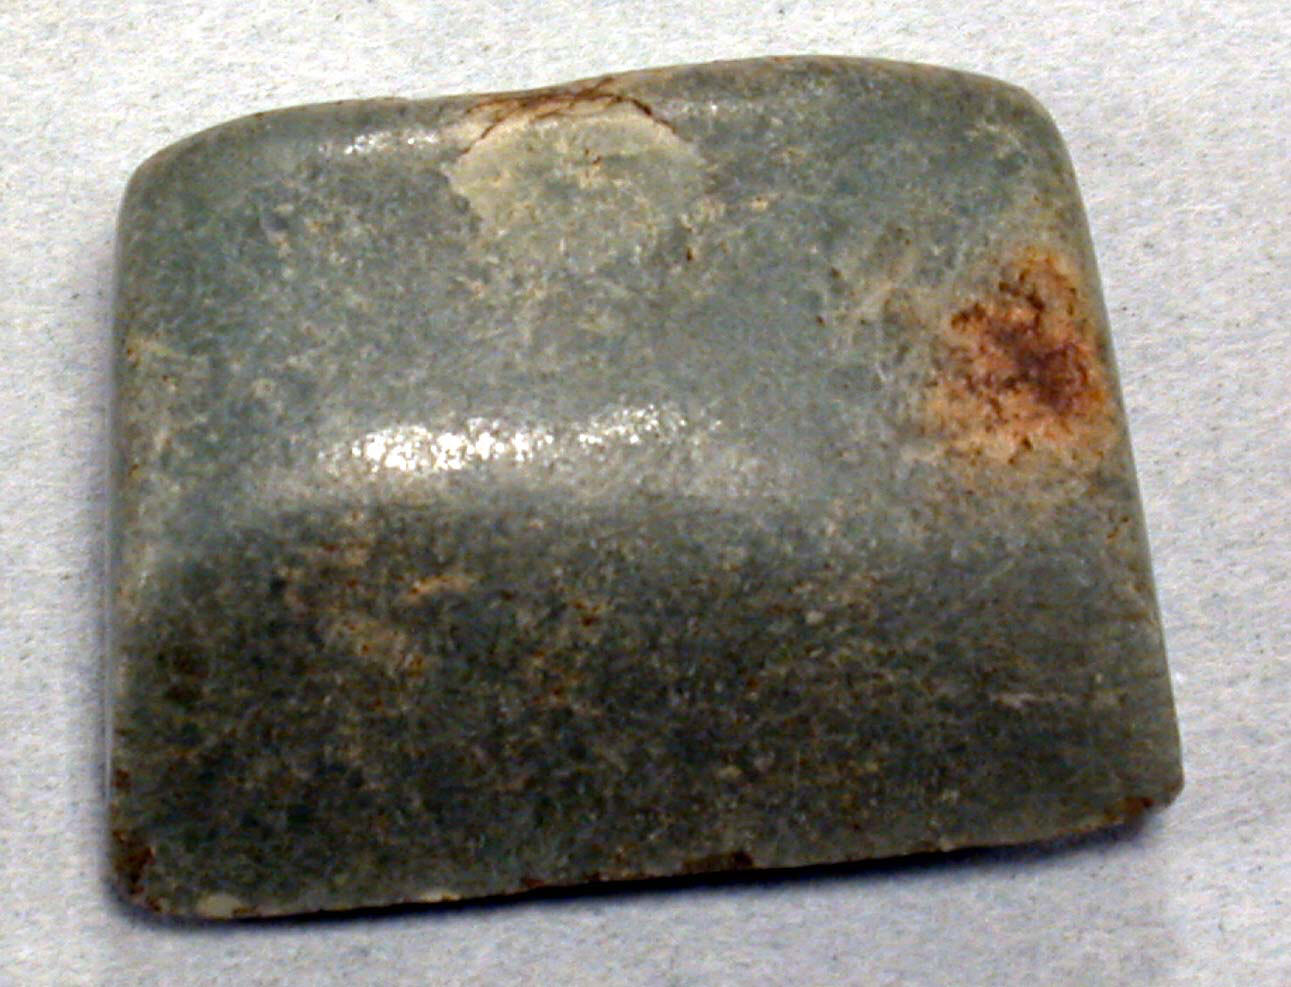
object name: chisel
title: Stone Chisel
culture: mexican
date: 1501-1600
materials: stone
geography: mexico